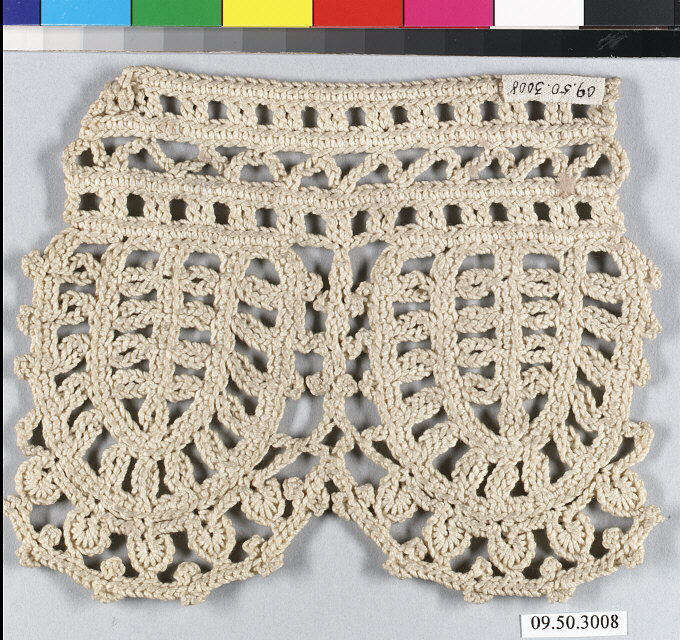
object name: piece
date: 1801-1900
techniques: crochet